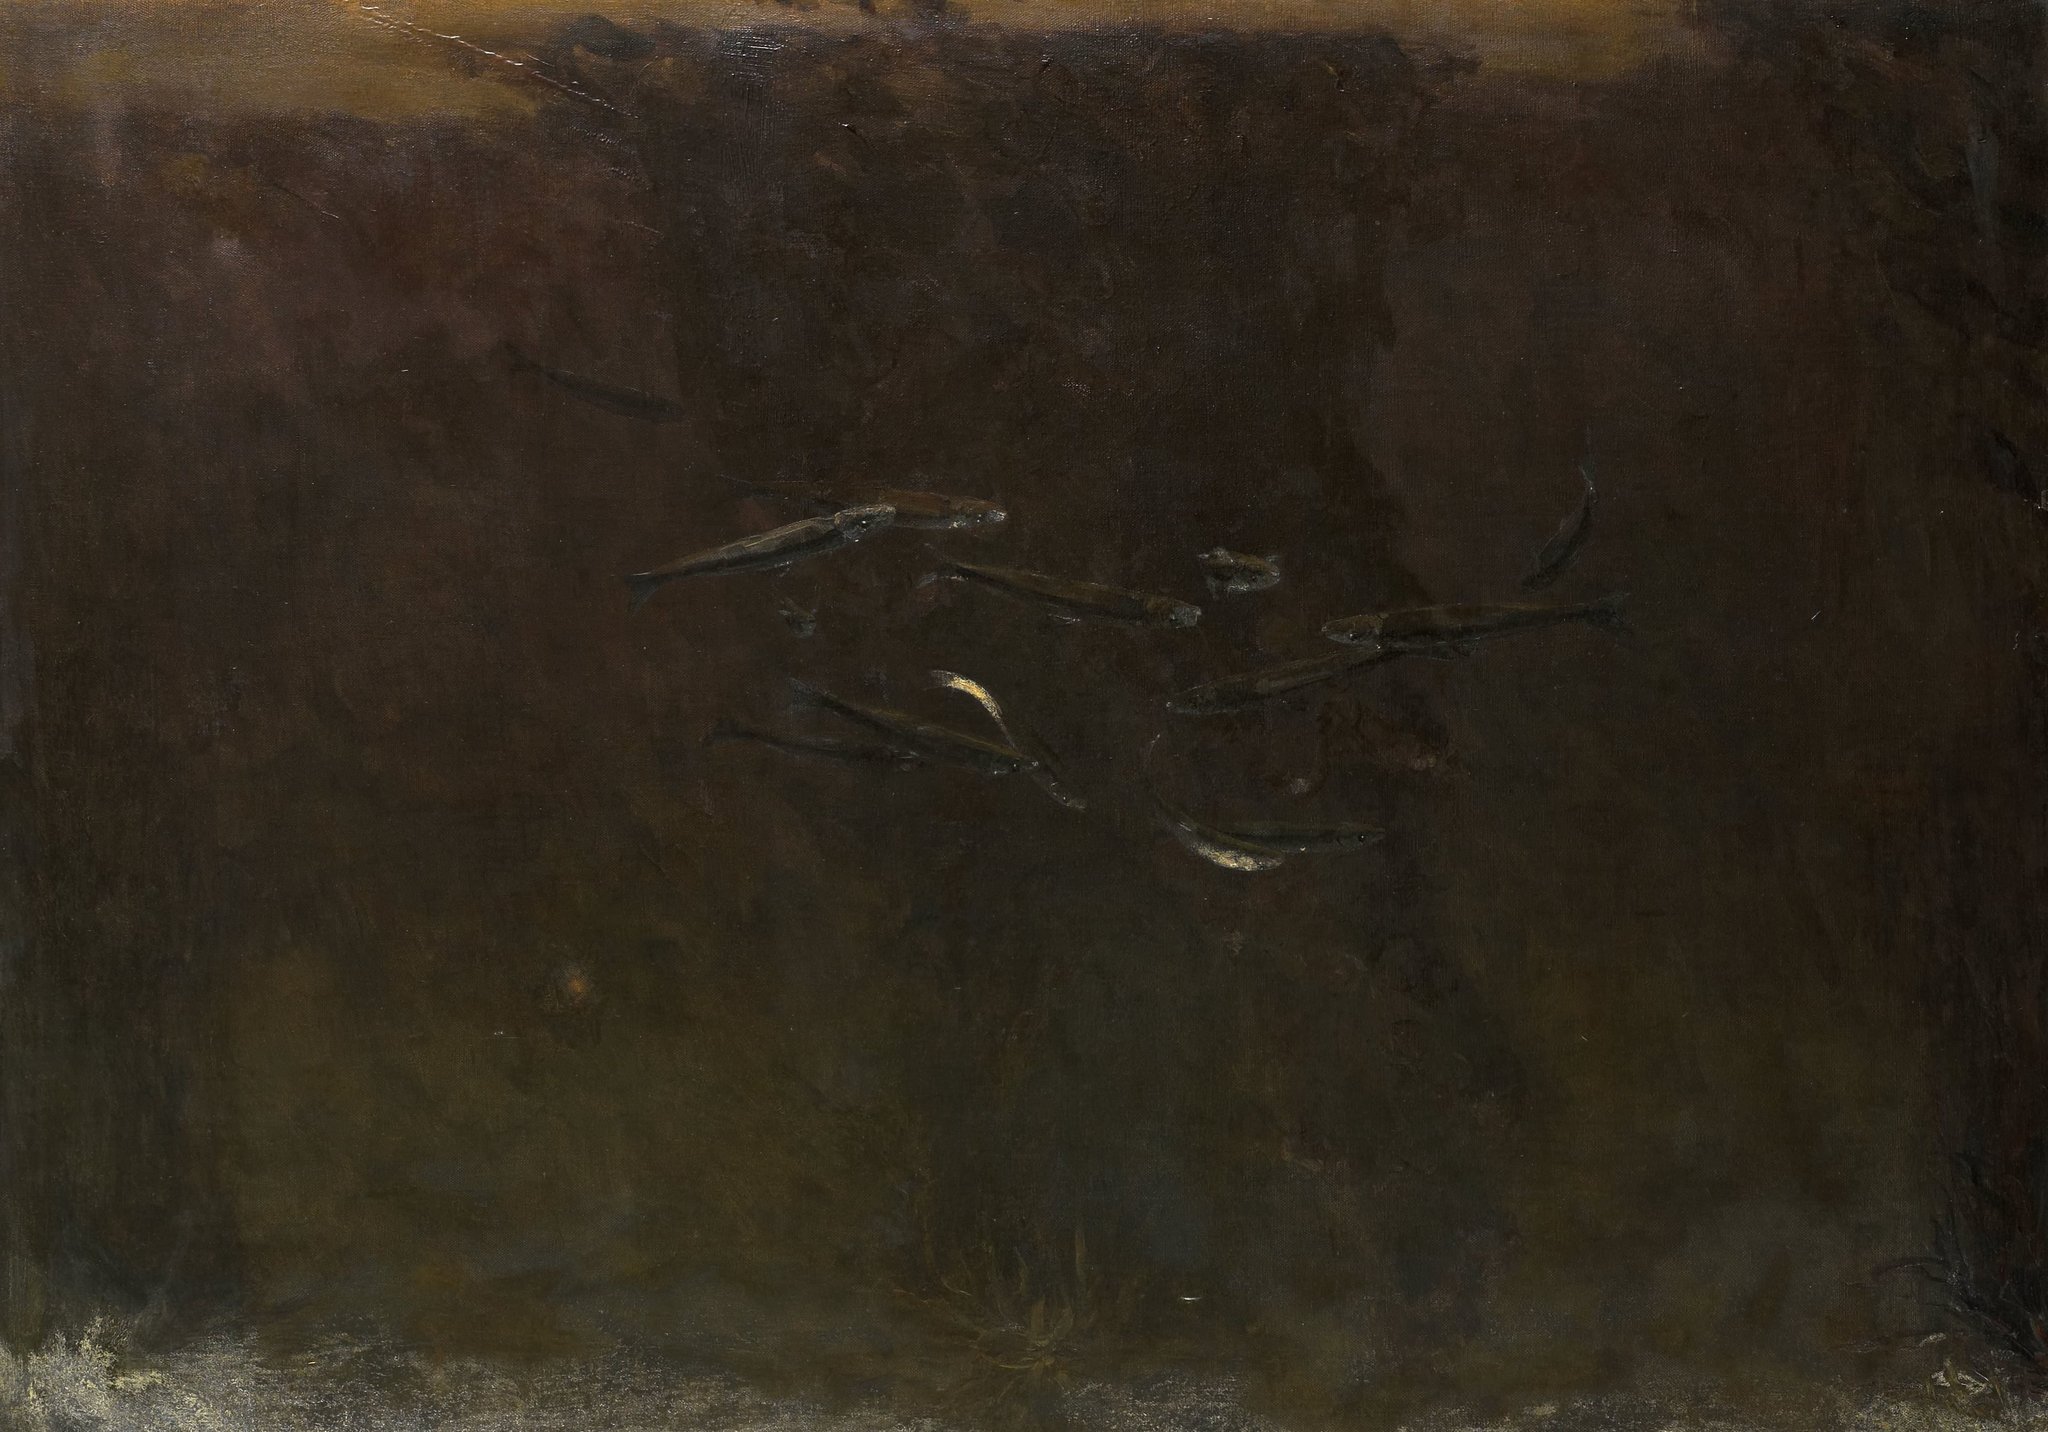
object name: painting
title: Fish in an Aquarium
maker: gerrit willem dijsselhof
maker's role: designer, draughtsman, print maker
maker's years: 1866-1924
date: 1890-1924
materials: canvas, oil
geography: netherlands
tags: aquarium, fishes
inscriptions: signature: ‘GWD’